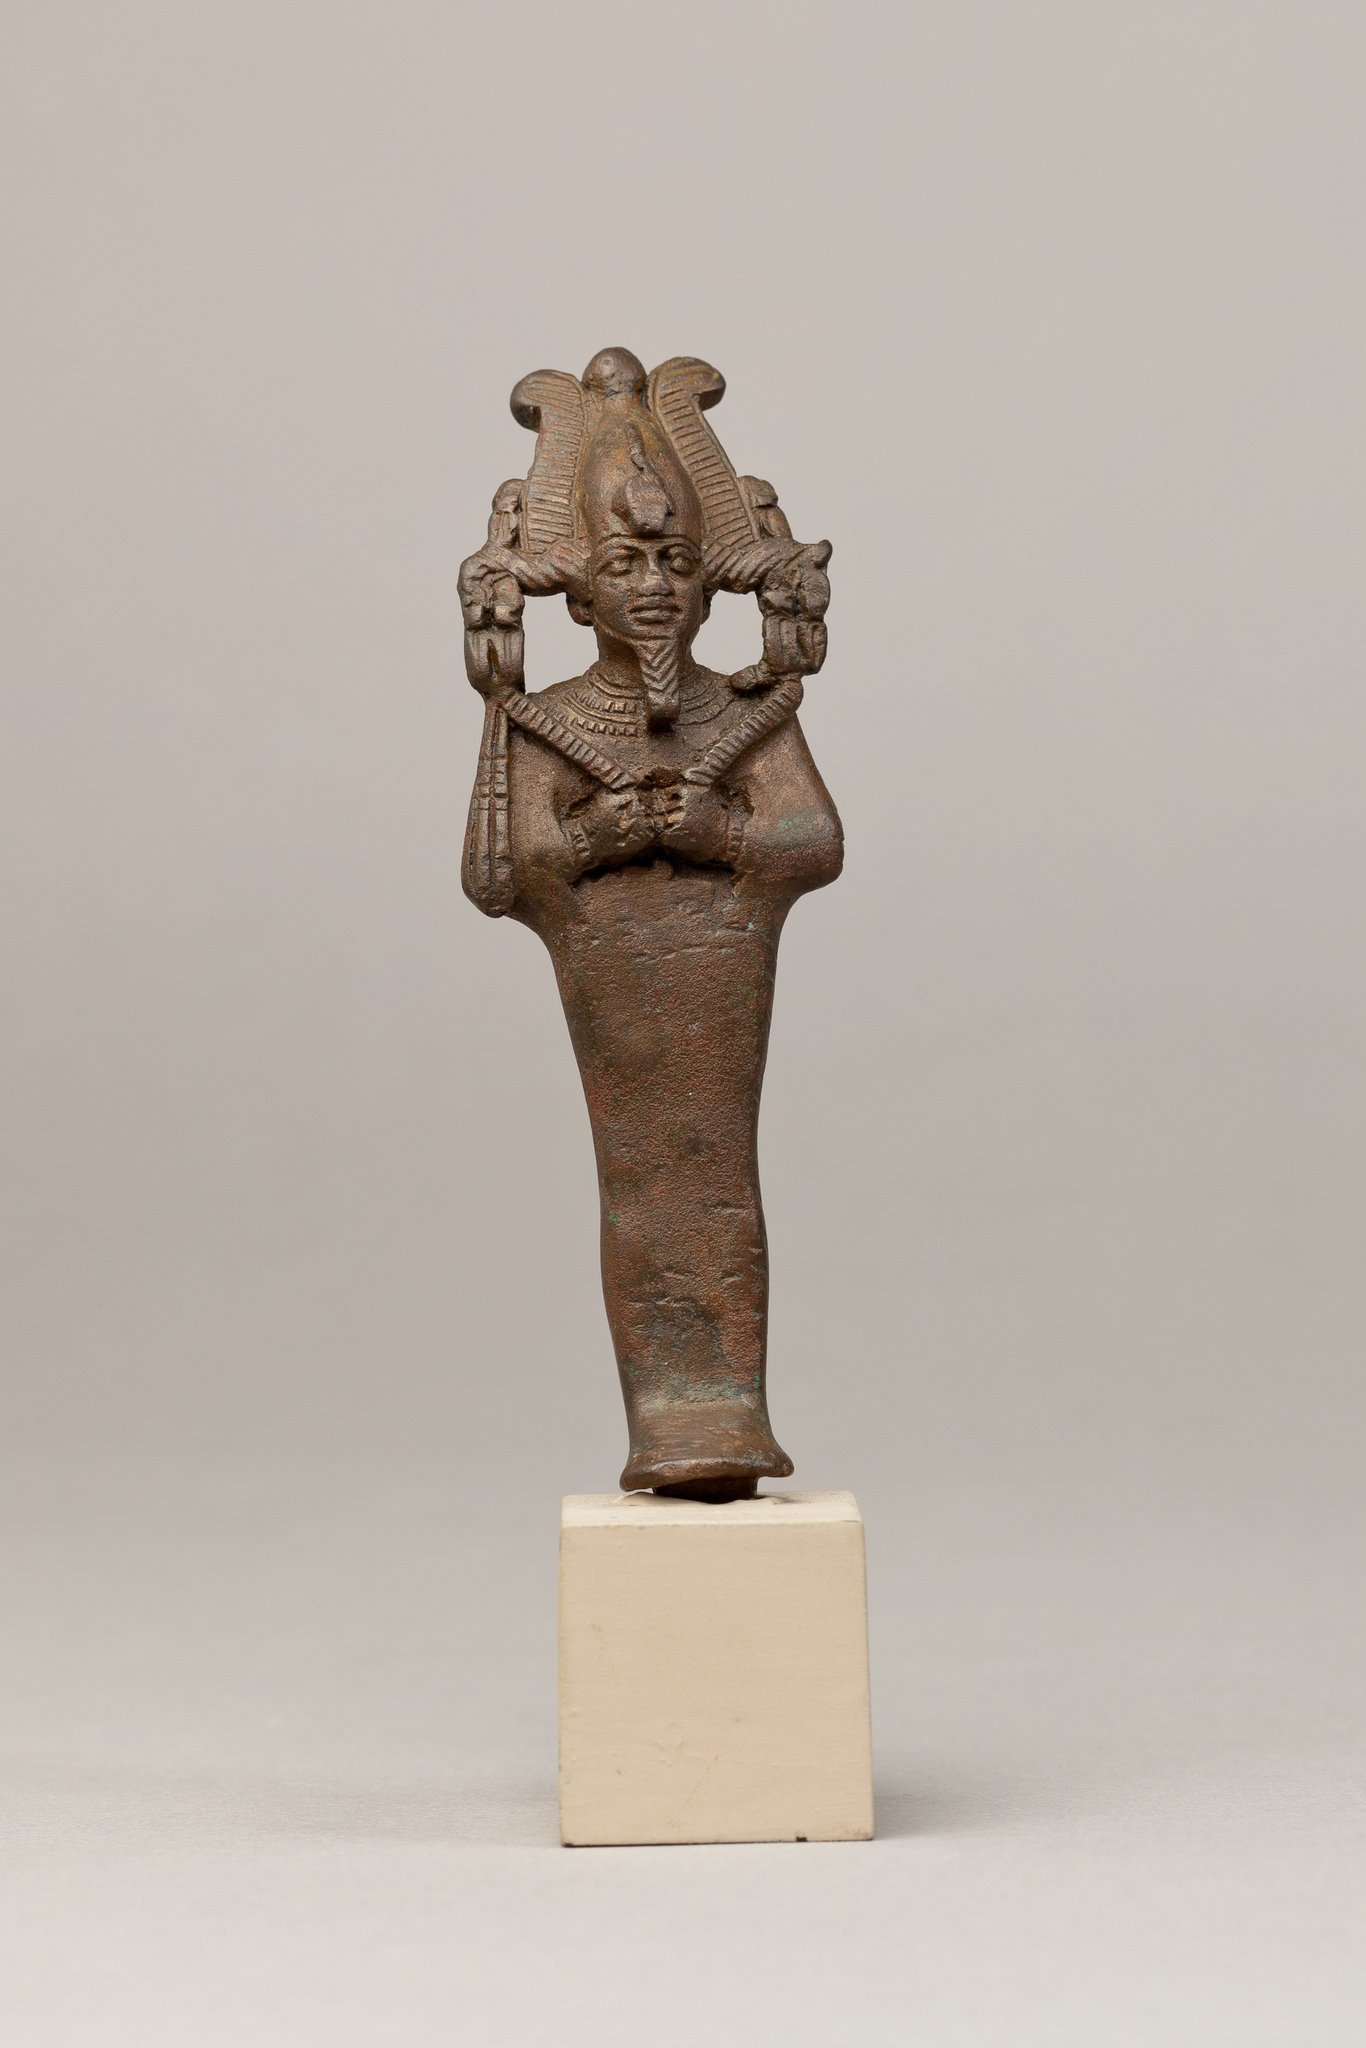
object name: statuette, osiris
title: Osiris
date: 664-630 BCE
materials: metal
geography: egypt